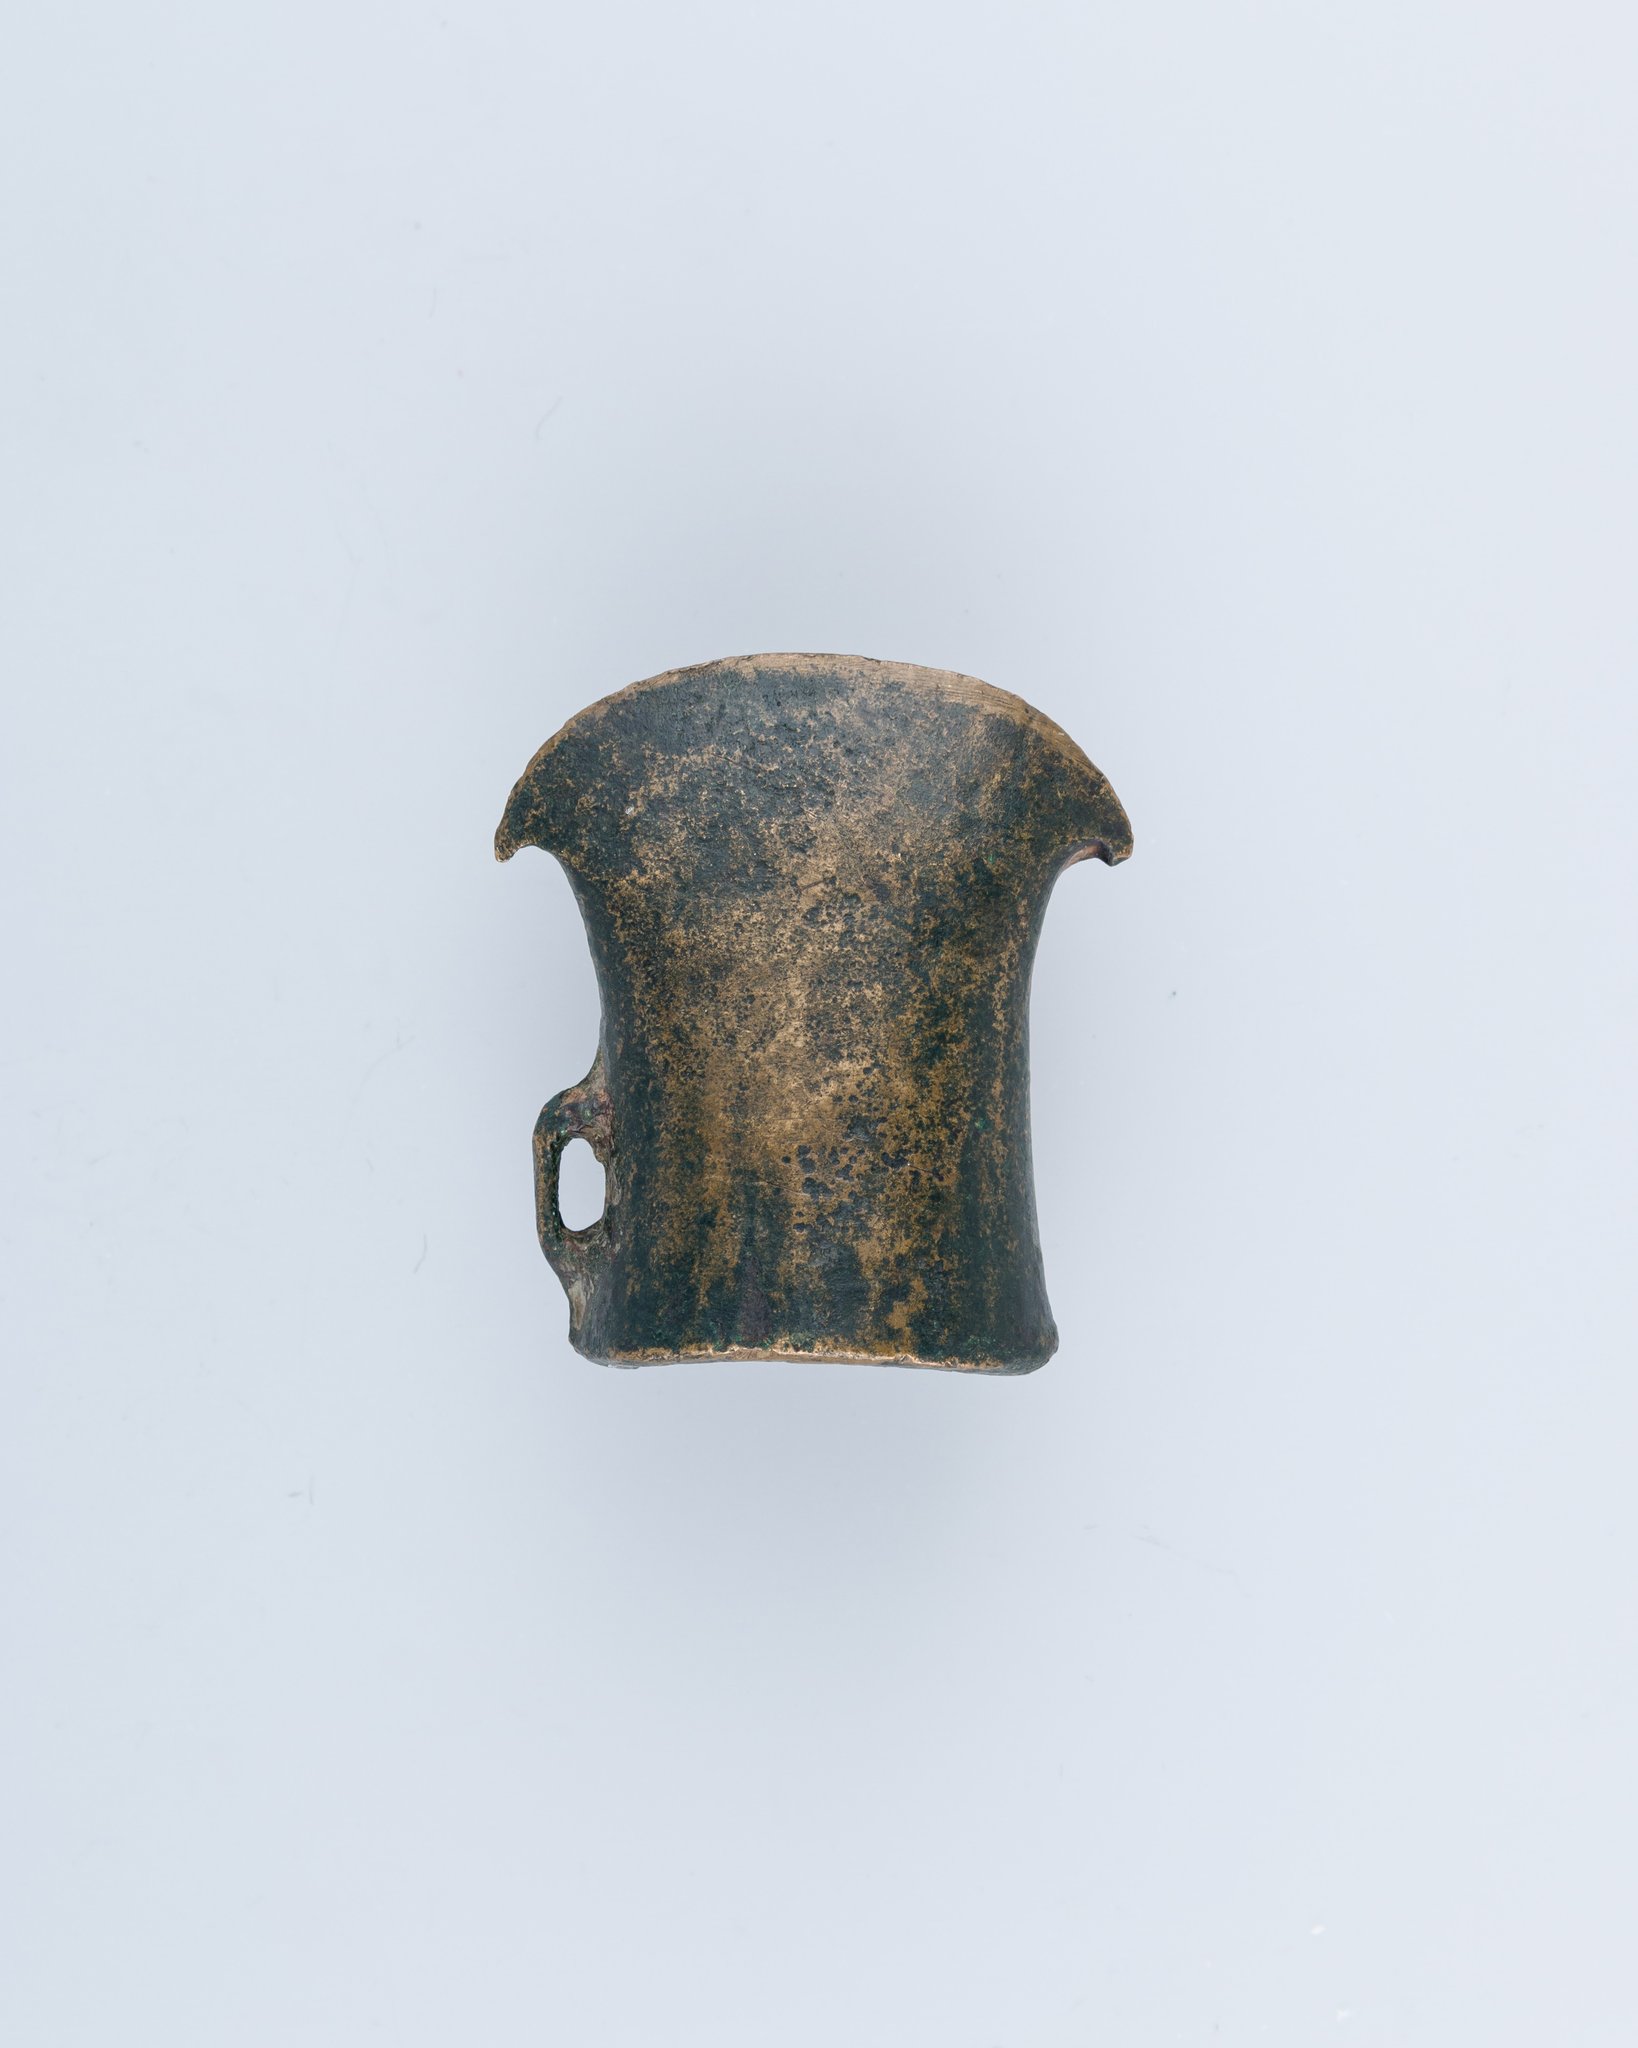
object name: socketed ax head celt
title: Socketed Ax-Head (Celt)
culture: irish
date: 800-500 BCE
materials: bronze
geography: ireland